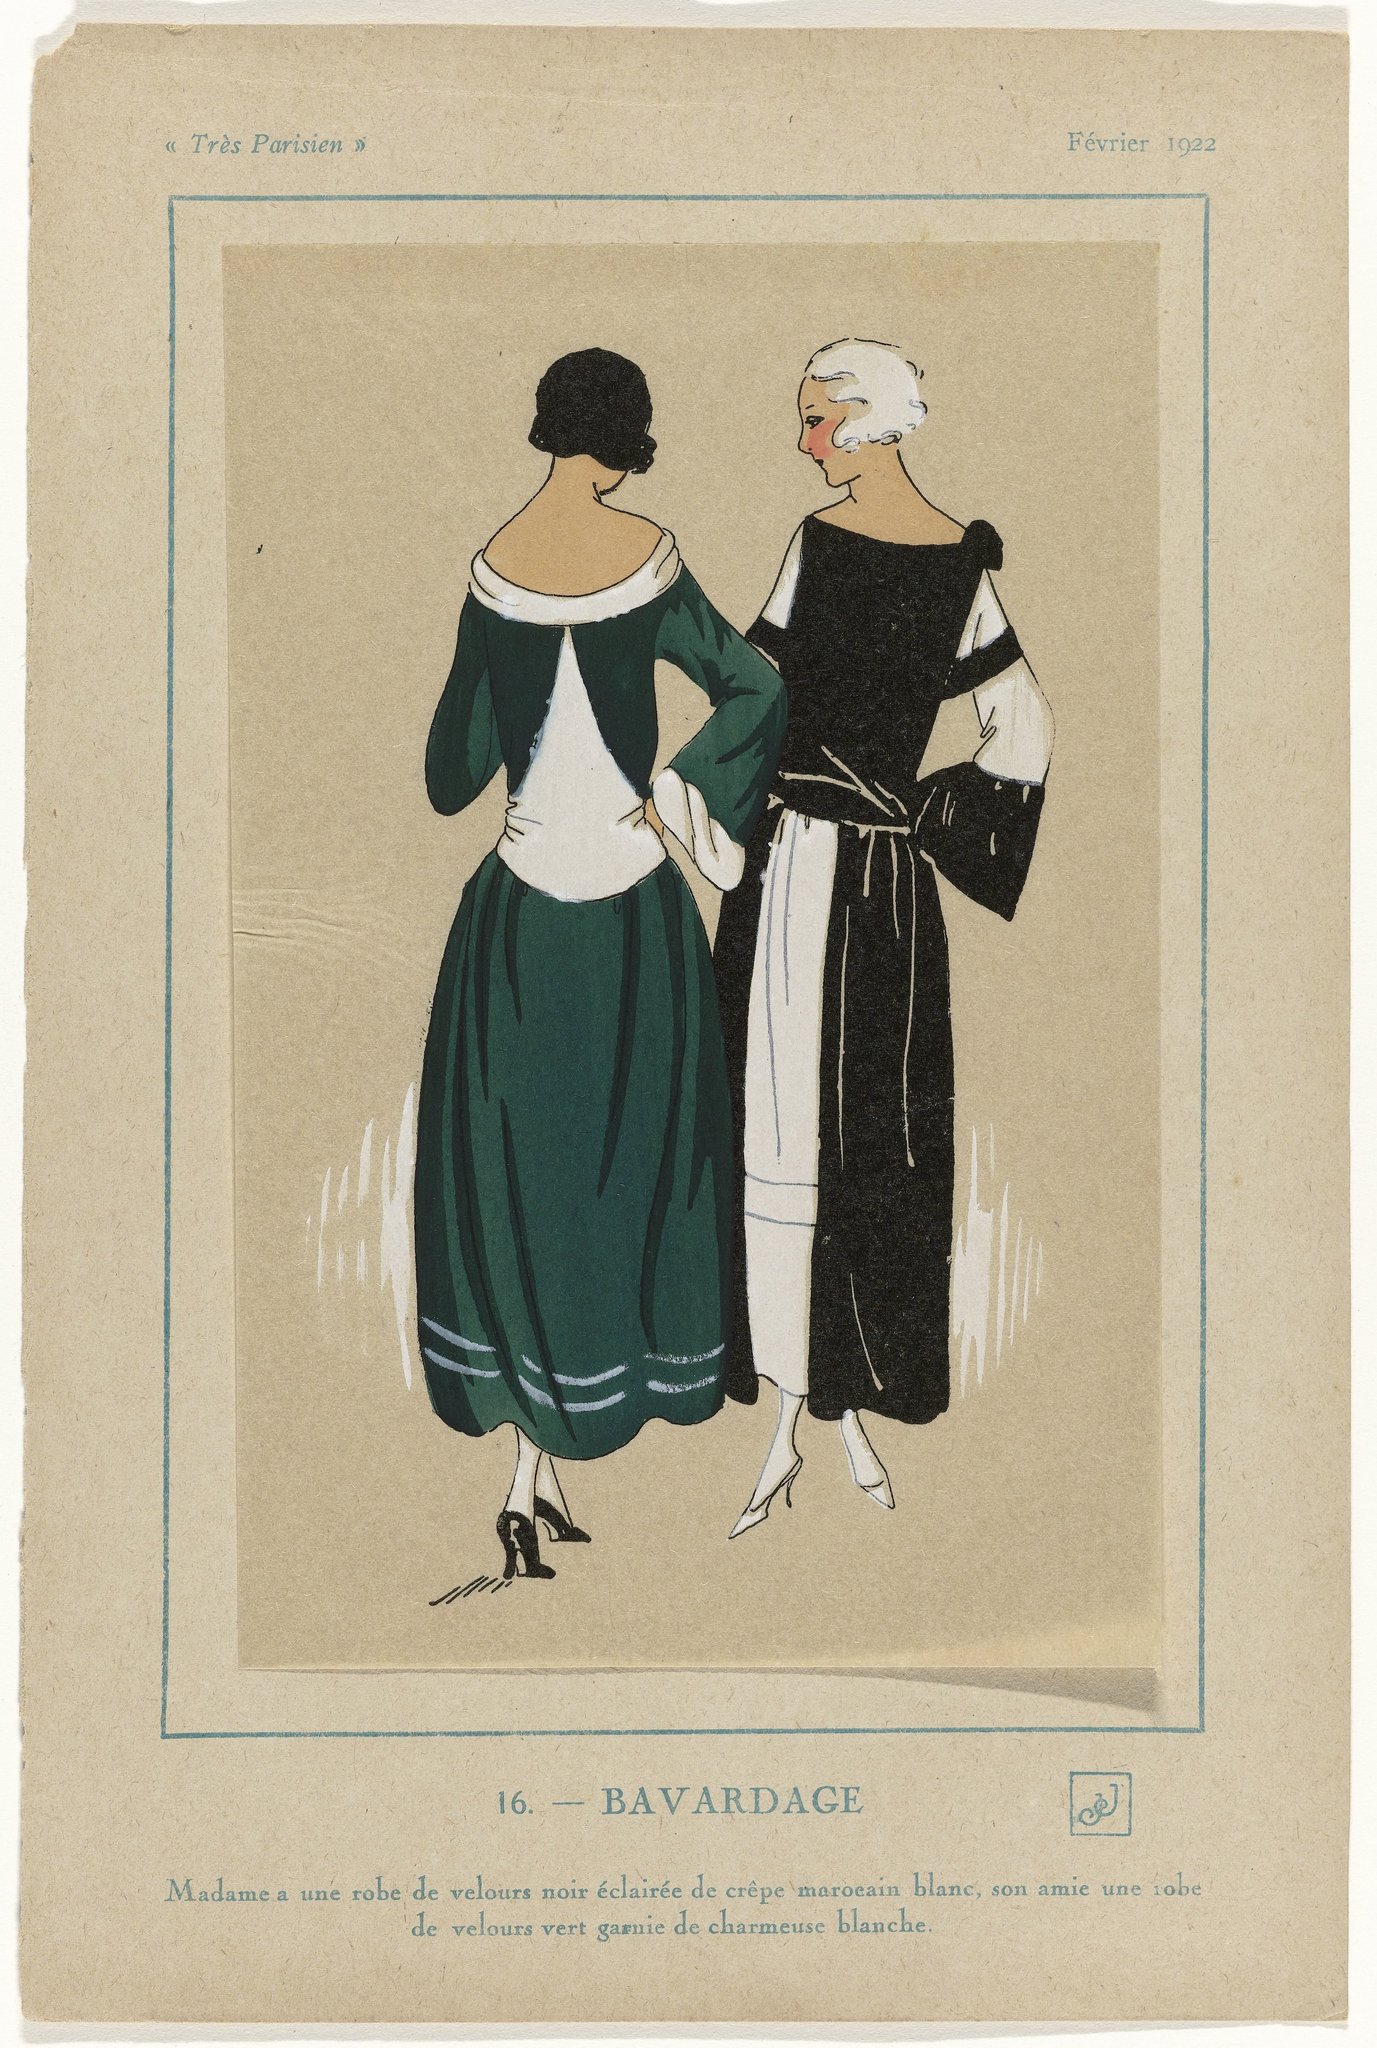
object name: fashion print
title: Très Parisien, février 1922: 16.- BAVARDAGE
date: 1922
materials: paper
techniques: hand coloring, letterpress printing, lithography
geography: paris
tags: fashion plates, dress, gown (+ women's clothes)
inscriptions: caption: ‘16. - BAVARDAGE / Madame a une robe de velours noir éclairée de crêpe marocain blanc, son amie une robe de velours vert garnie de charmeuse blanche.’, title: ‘Très Parisien / Février 1922’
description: Zwarte fluwelen japon versierd met Marokaanse crêpe; groene fluwelen japon met witte charmeuse. Prent uit het modetijdschrift Très Parisien (1920-1936).